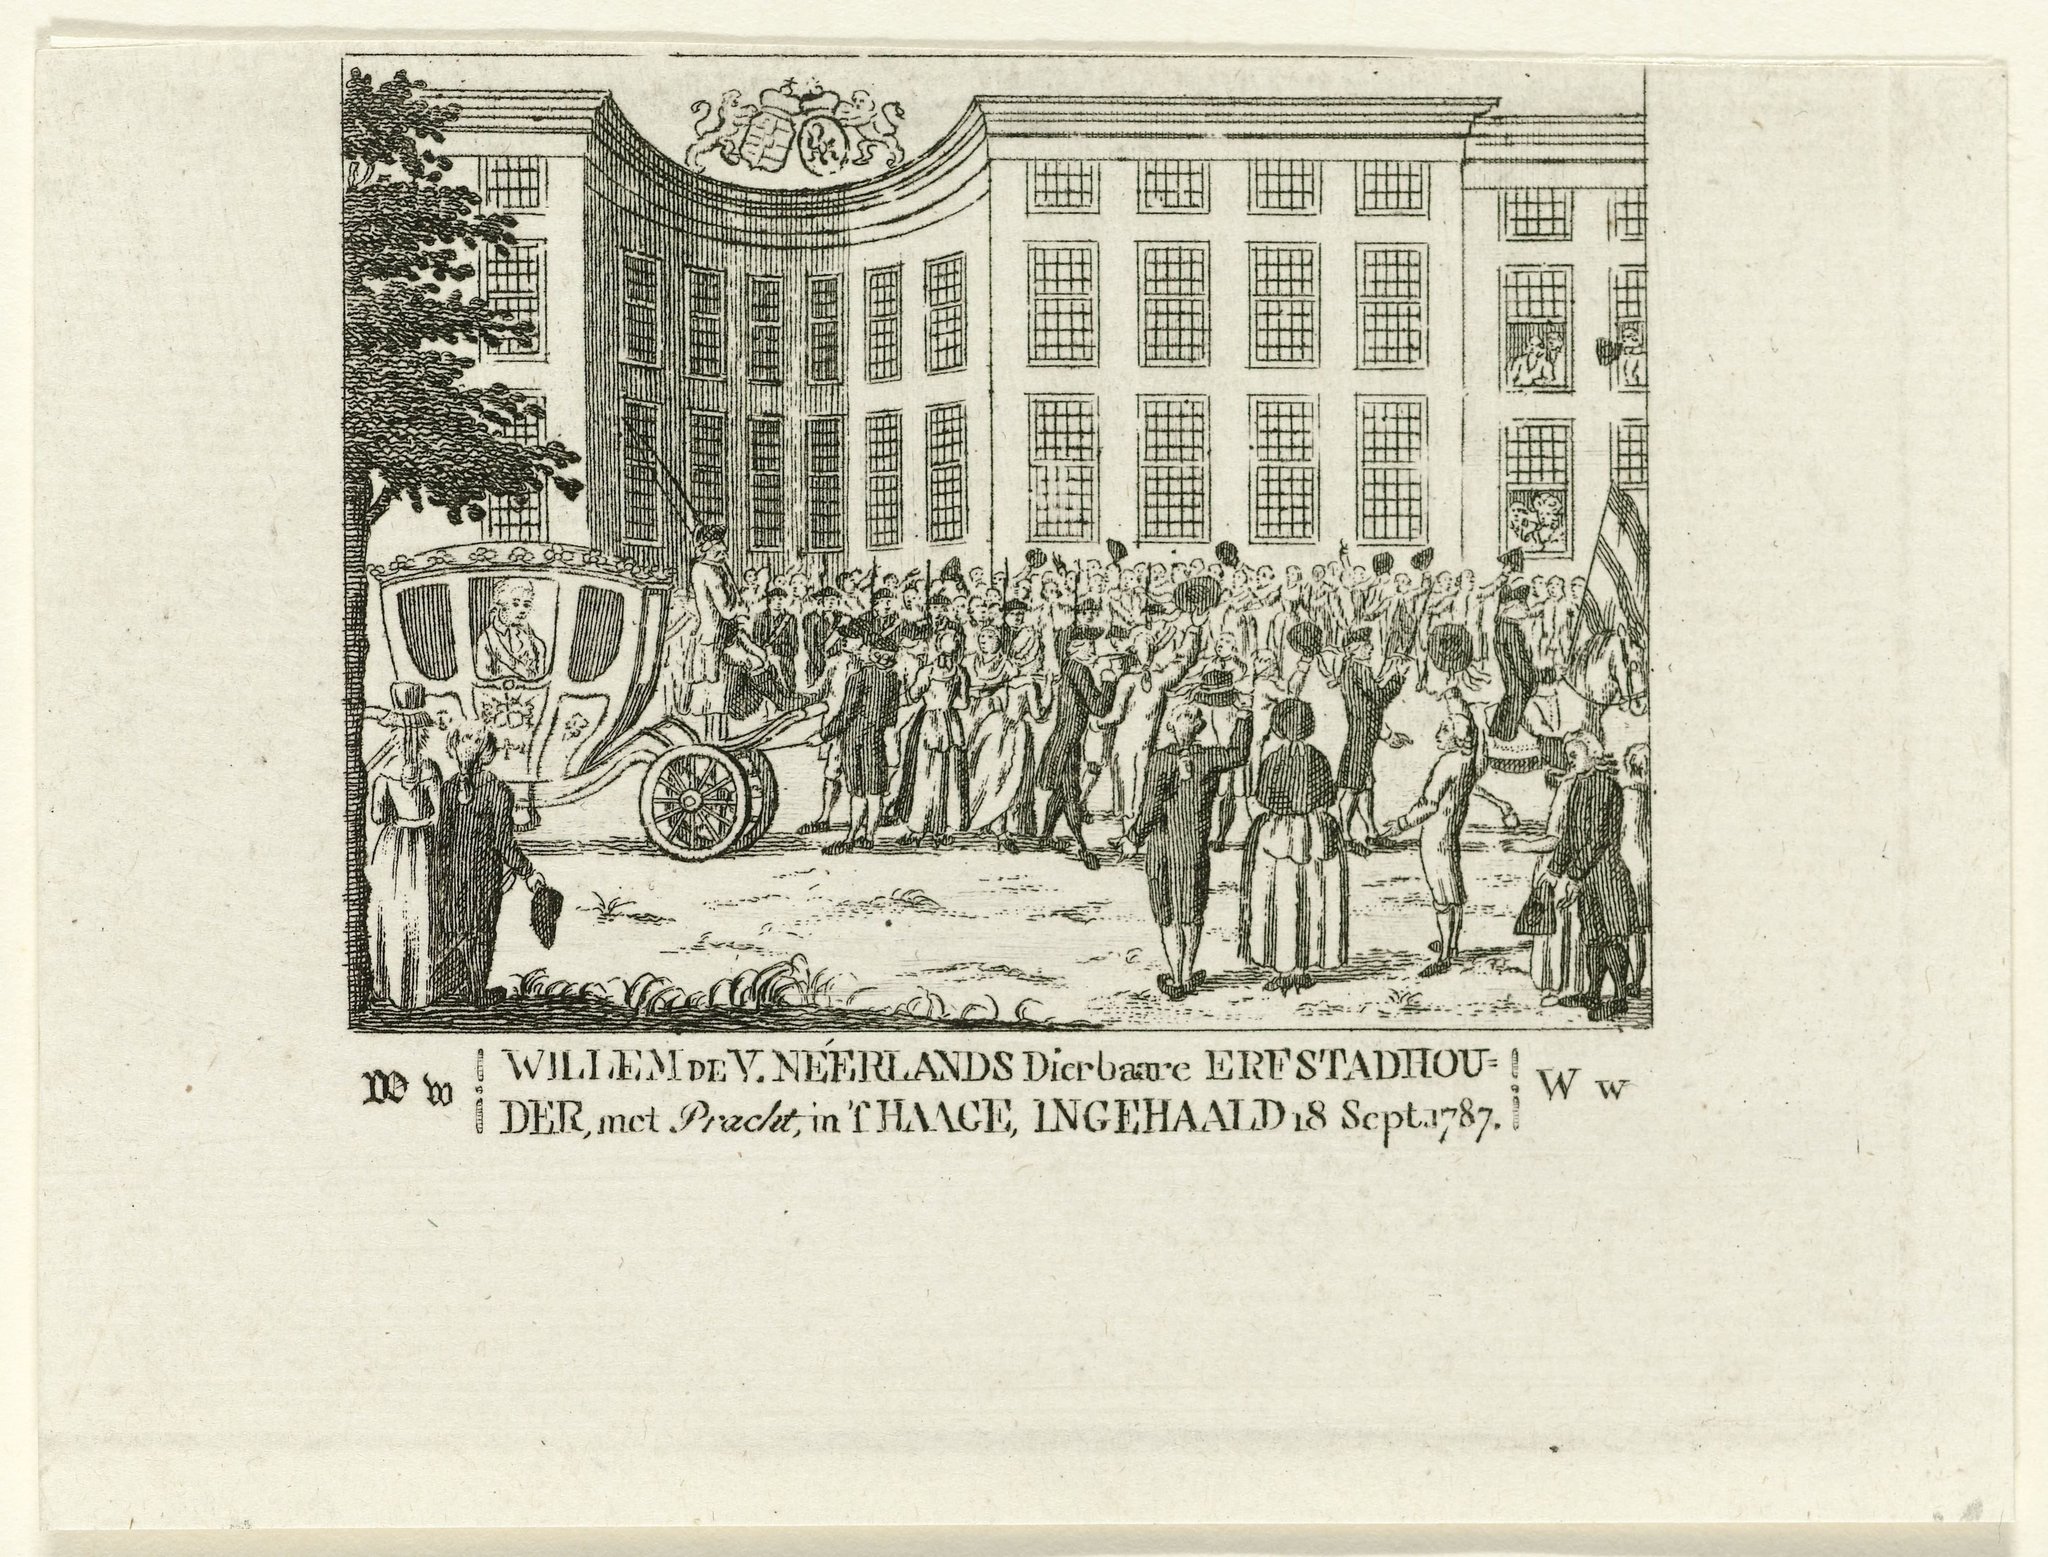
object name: print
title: Willem de V. Neerlands Dierbaare Erfstadhouder, met Pracht, in 's Haage, Ingehaald 18 Sept. 1787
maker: Anonymous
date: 1787-1790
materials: paper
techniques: etching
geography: northern netherlands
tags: william v (prince of orange), public festivities at other royal events, not meant or mentioned above, human being(s) drawing or pushing a vehicle not usually propelled by manpower, the hague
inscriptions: collector's mark: Lugt 2228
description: Gebruikt als illustratie in: Vorstelyke koninglyke en princelyke atlas, en dagboek van Nederlandsche gebeurtenissen, in de laatste jaaren voorgevallen. En oprecht vaderlandsch (...) A.B. boek. Amsterdam: Willem Coertse, [1790].